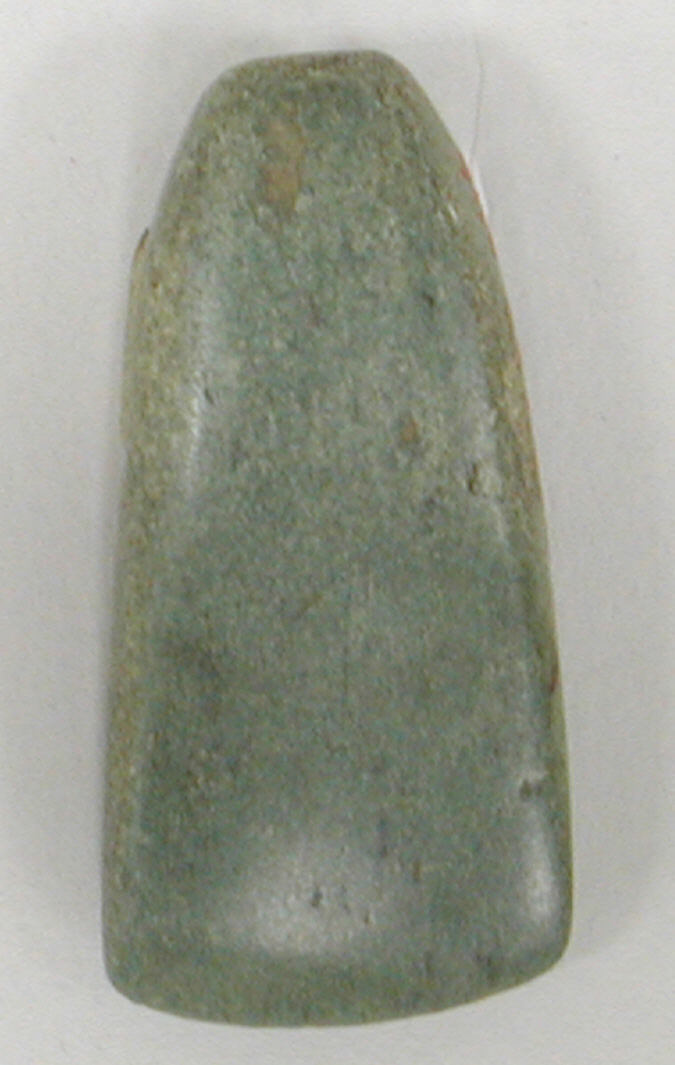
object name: celt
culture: maya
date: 1501-1600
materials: stone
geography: guatemala